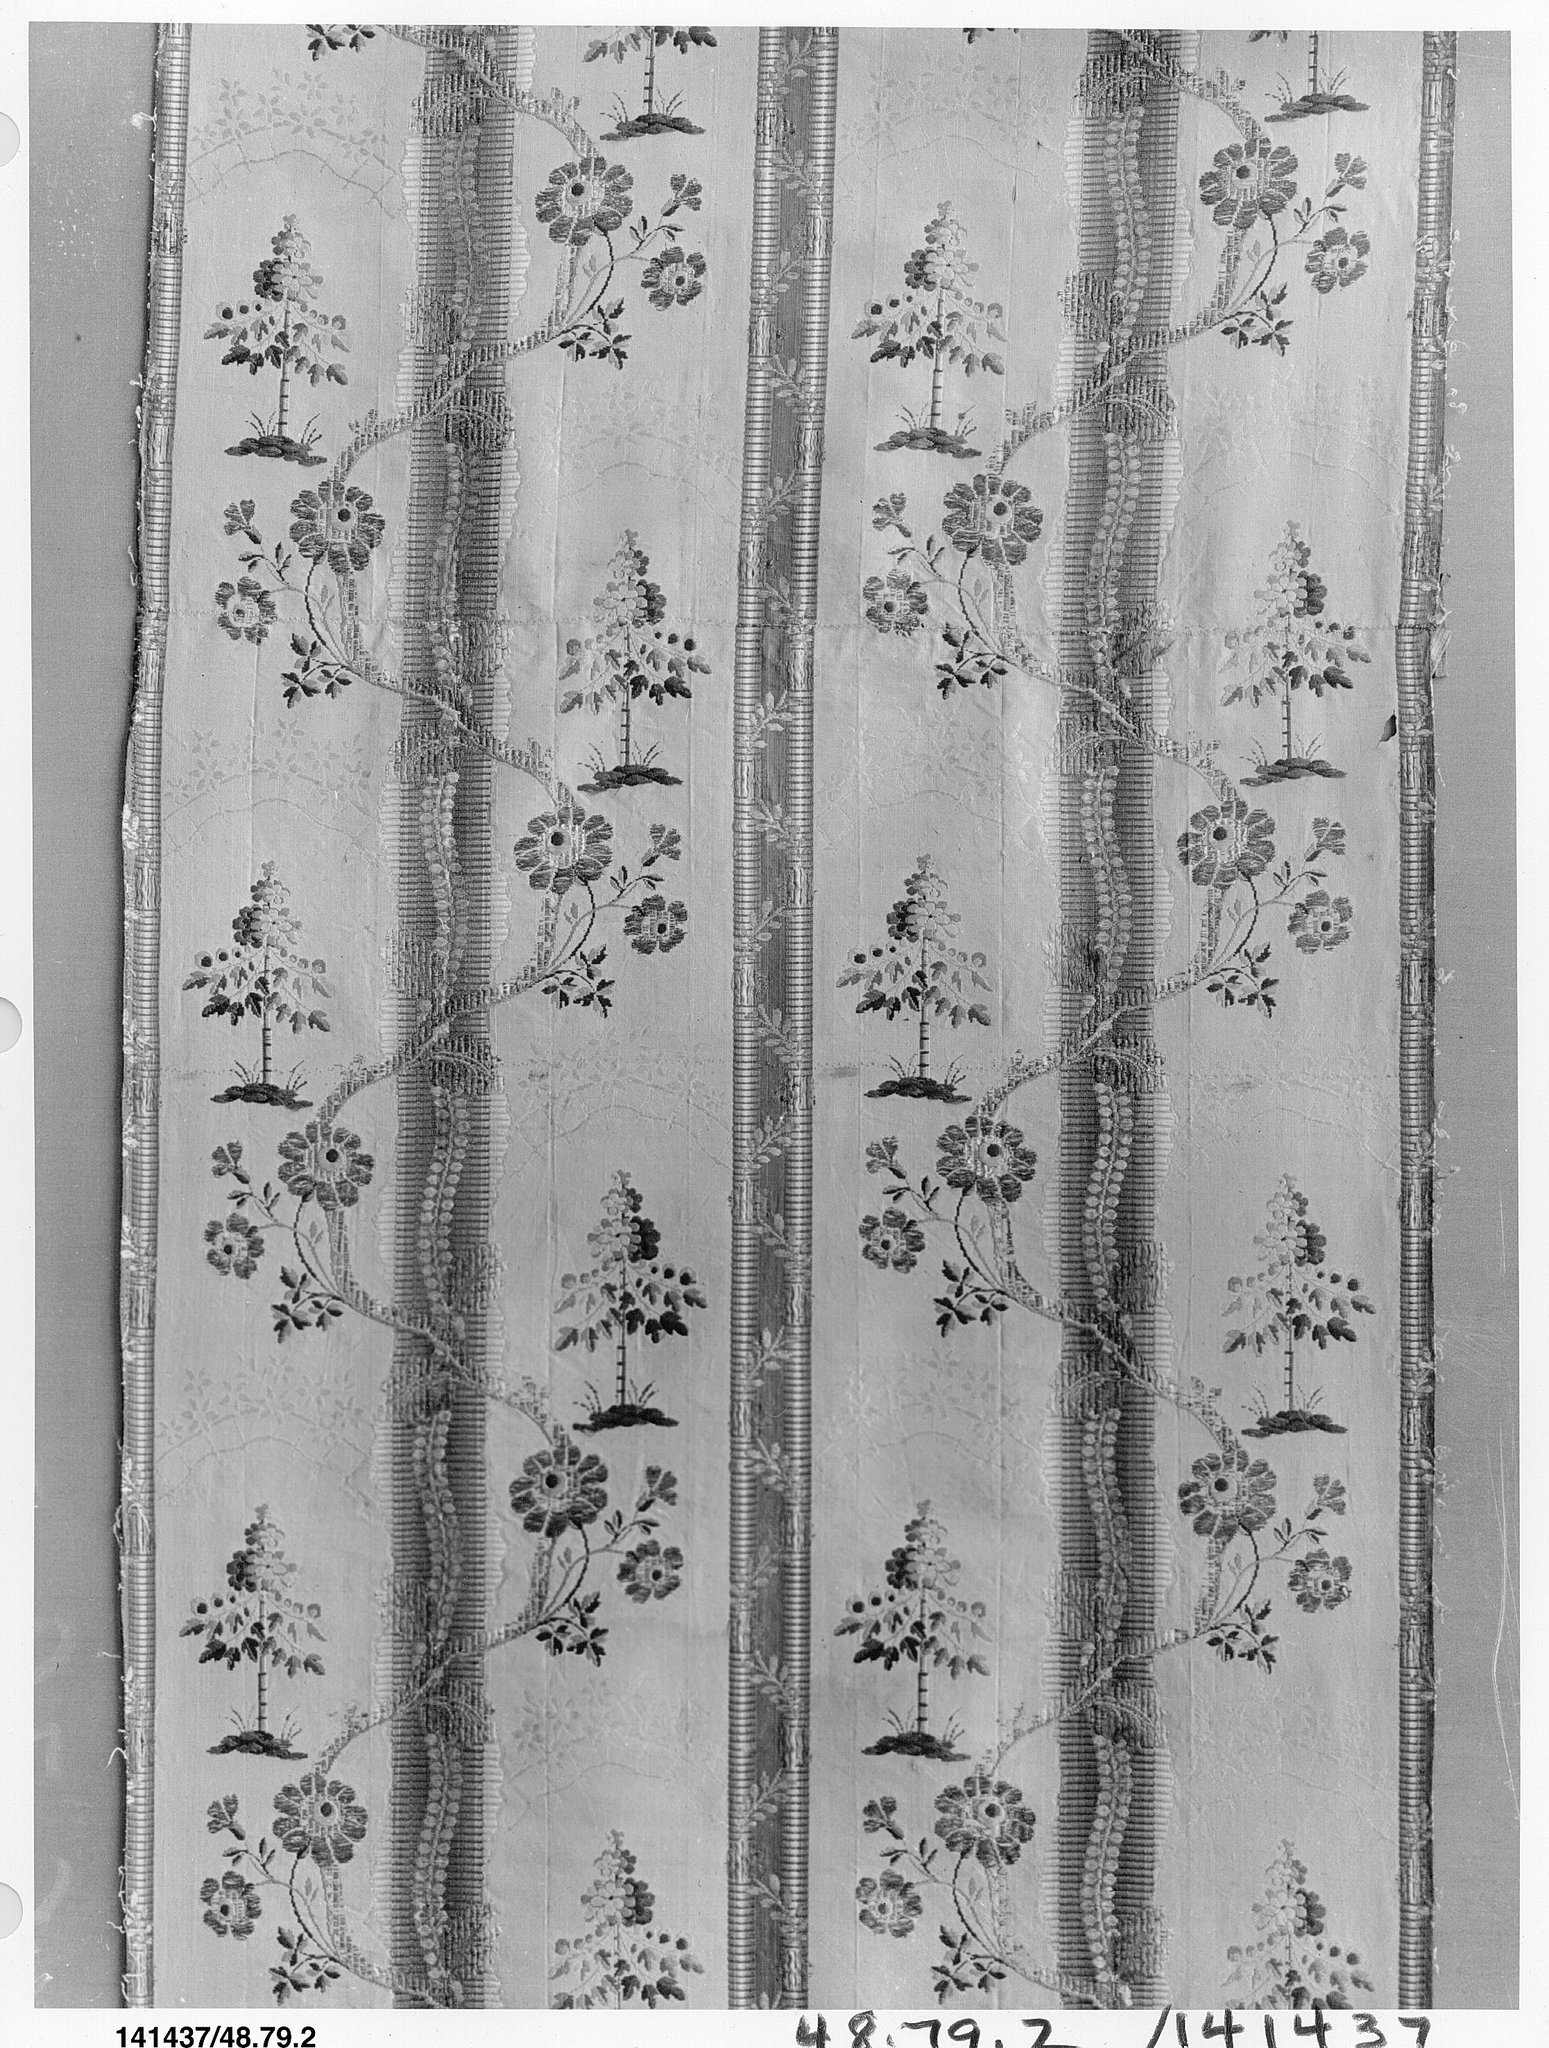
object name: piece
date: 1767-1800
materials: metal thread, silk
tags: flowers,plants,leaves